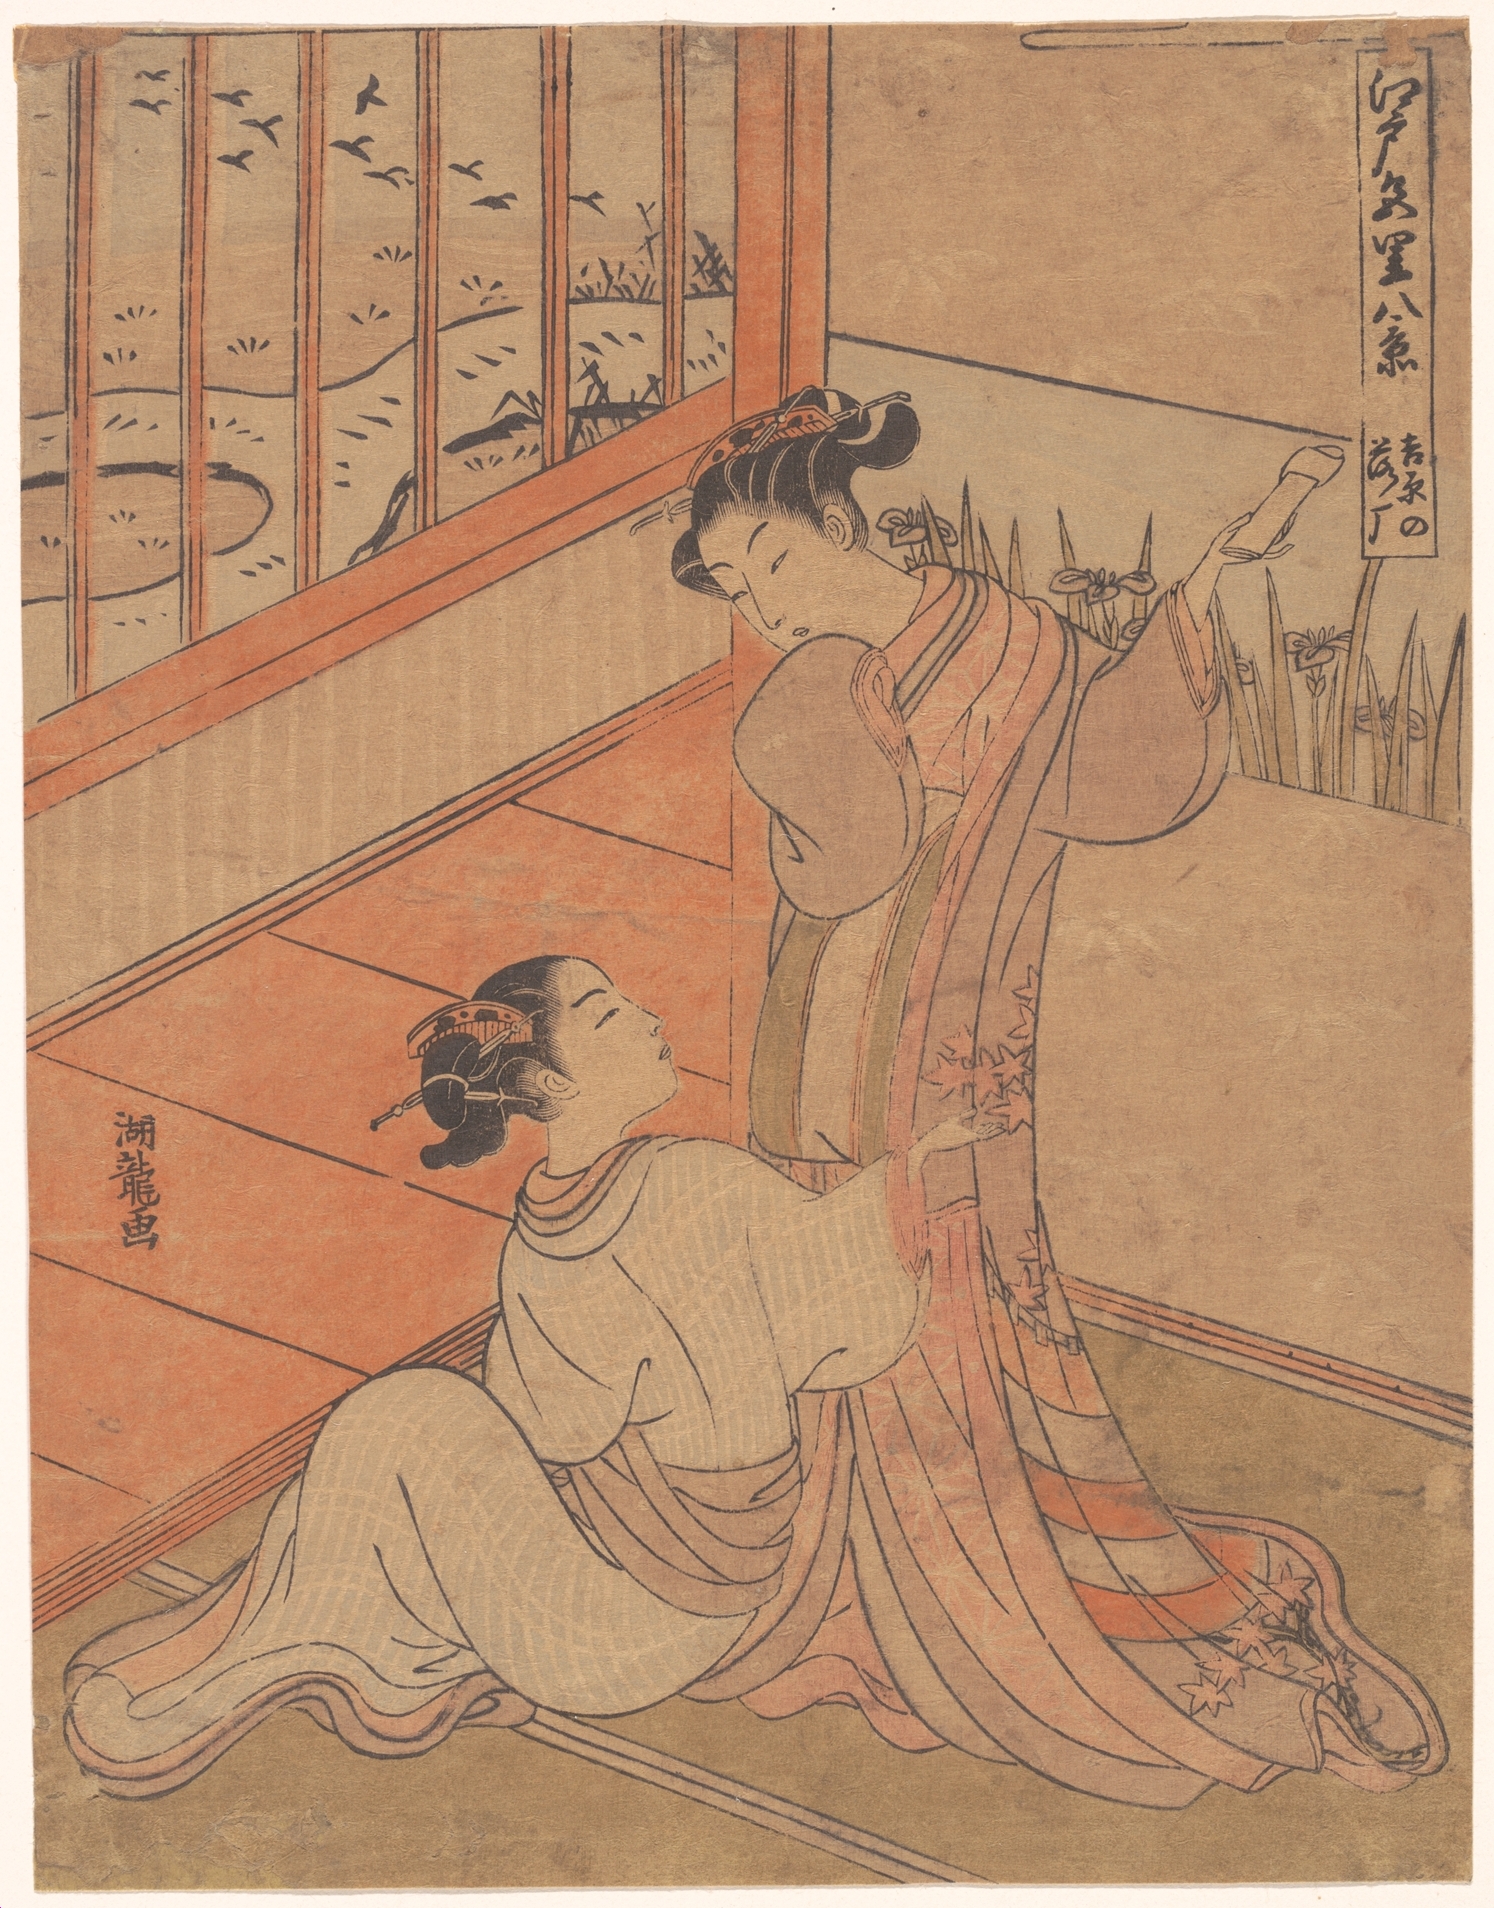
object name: print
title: The Flying Down of Wild Geese at Yoshiwara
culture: japanese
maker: isoda koryūsai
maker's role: artist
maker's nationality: japanese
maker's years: 1735-1790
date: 1770-1790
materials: ink, paper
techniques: woodblock print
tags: birds,women